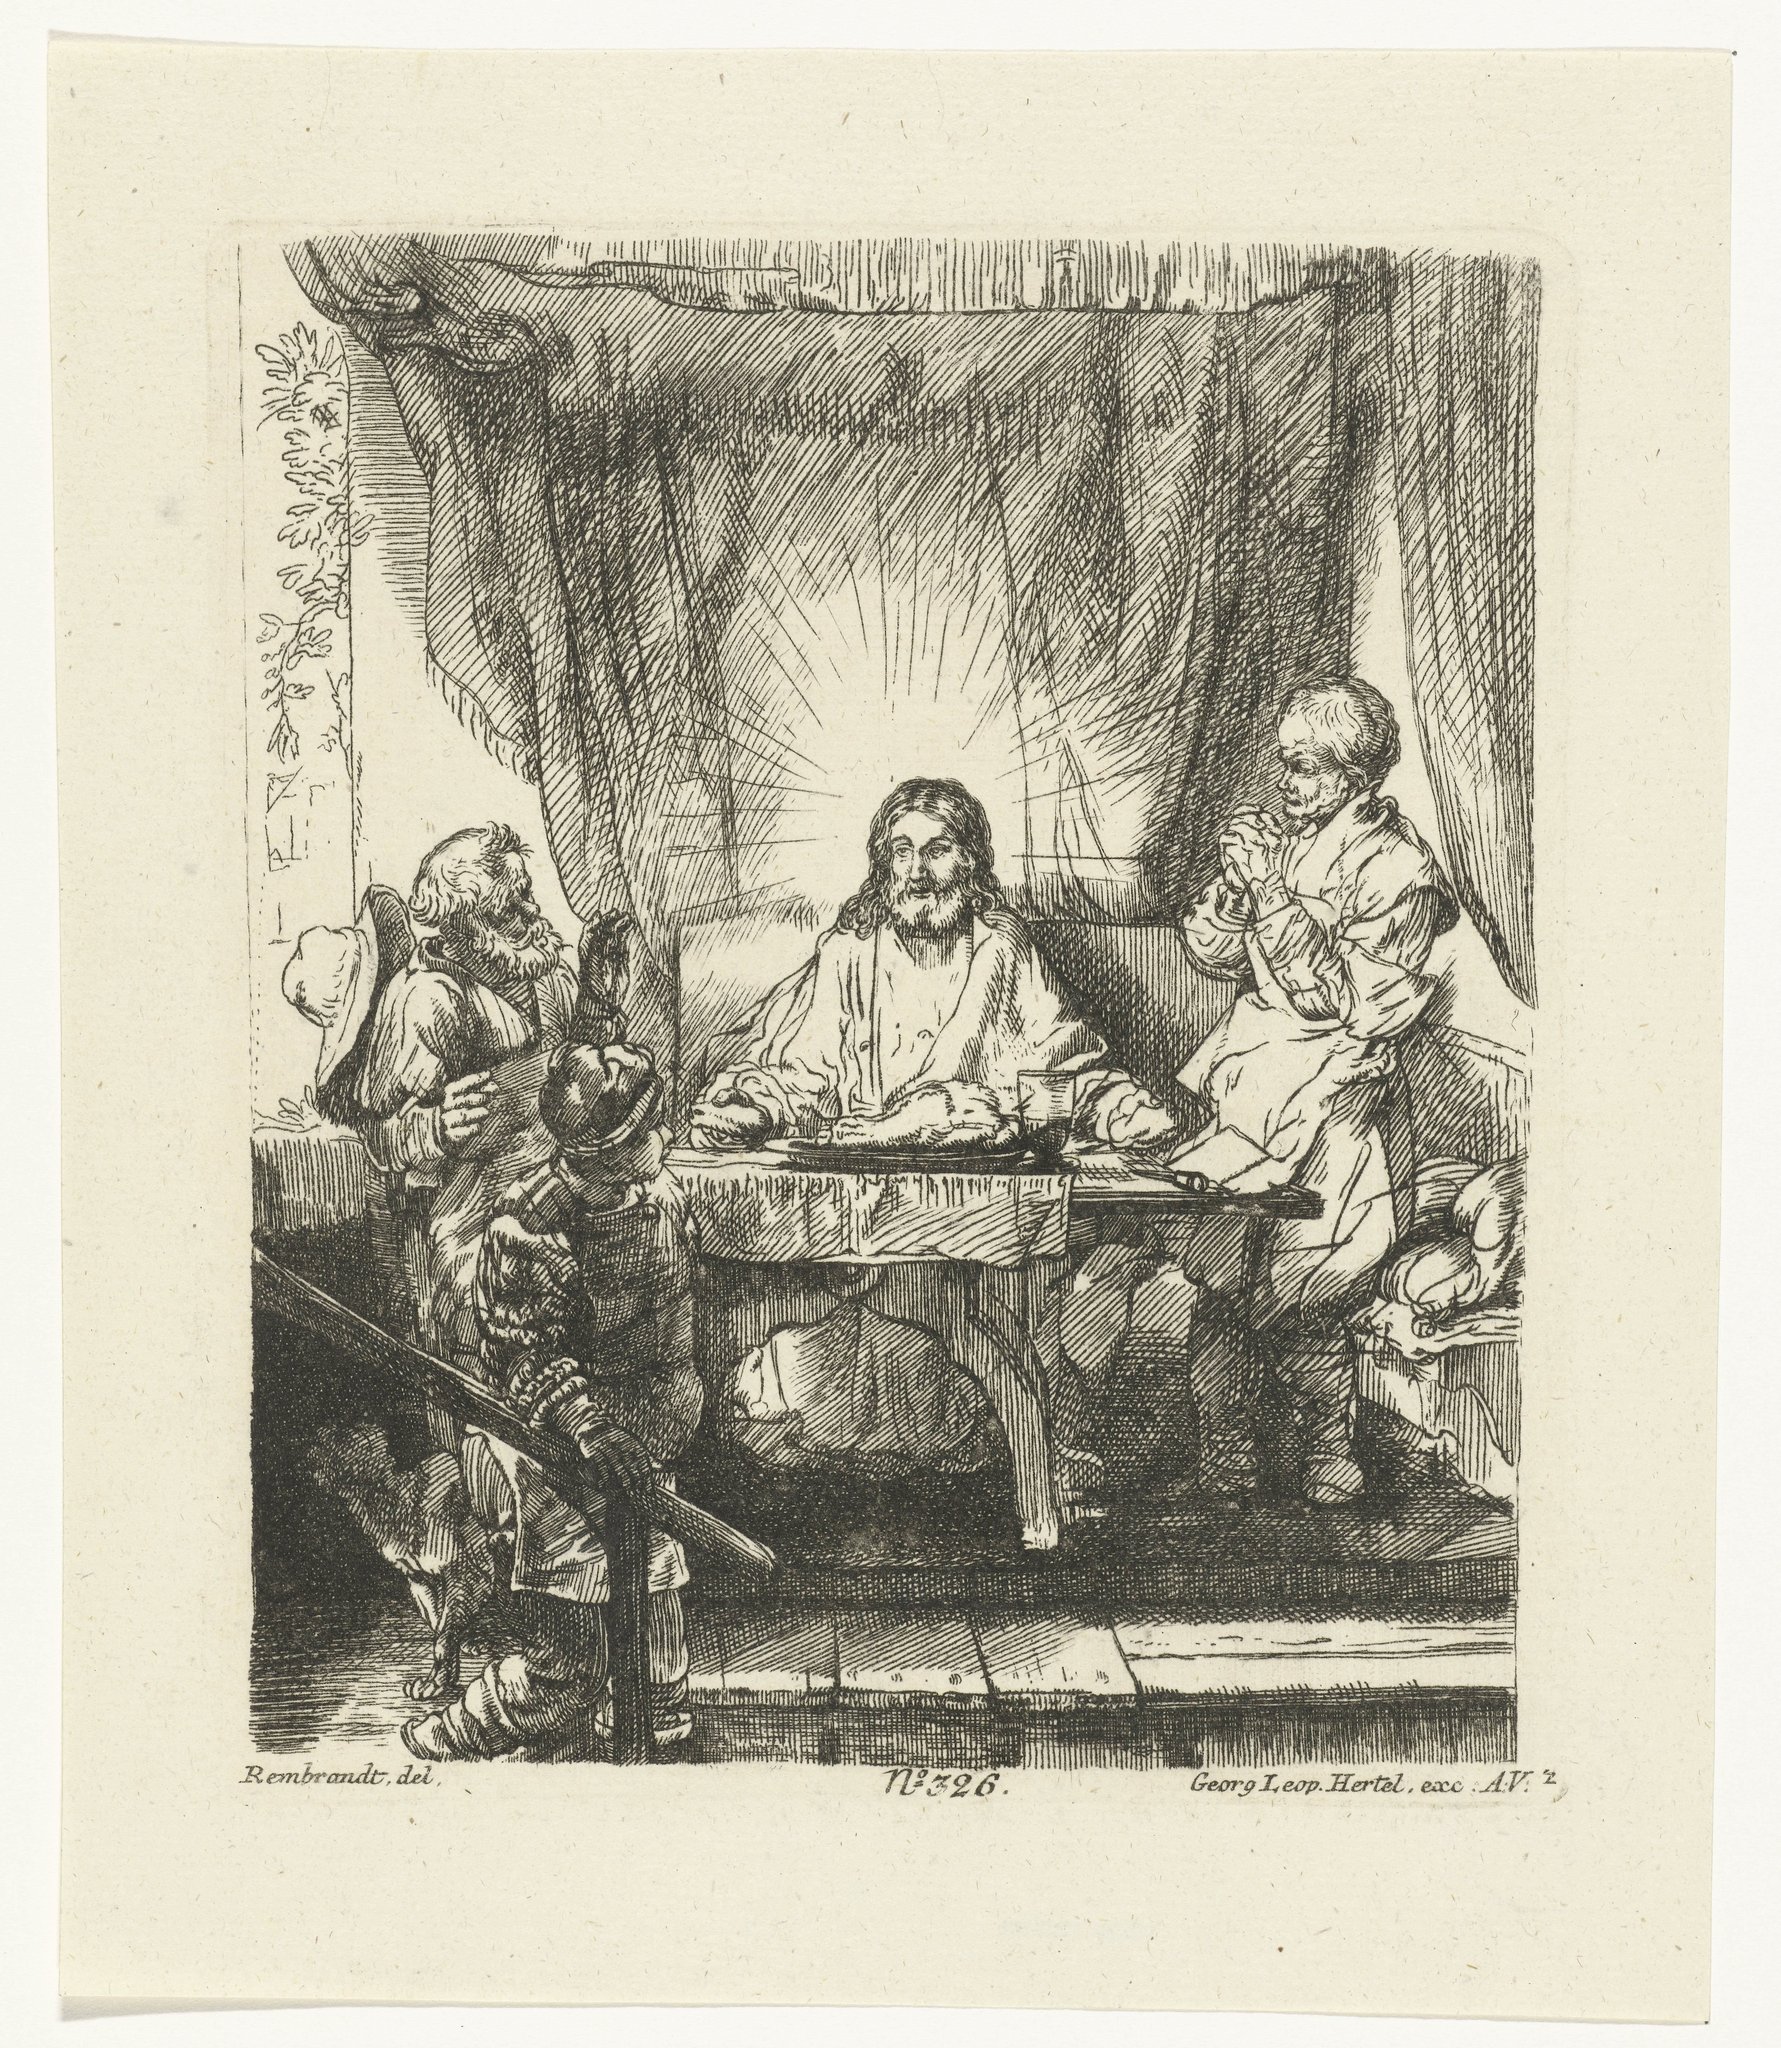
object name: print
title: Christ at Emmaus: the larger plate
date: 1750-1778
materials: paper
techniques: etching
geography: augsburg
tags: the supper at emmaus: christ is recognized while blessing or breaking the bread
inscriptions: collector's mark: Lugt 240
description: Spiegelbeeldige kopie naar de gelijknamige prent van Rembrandt.